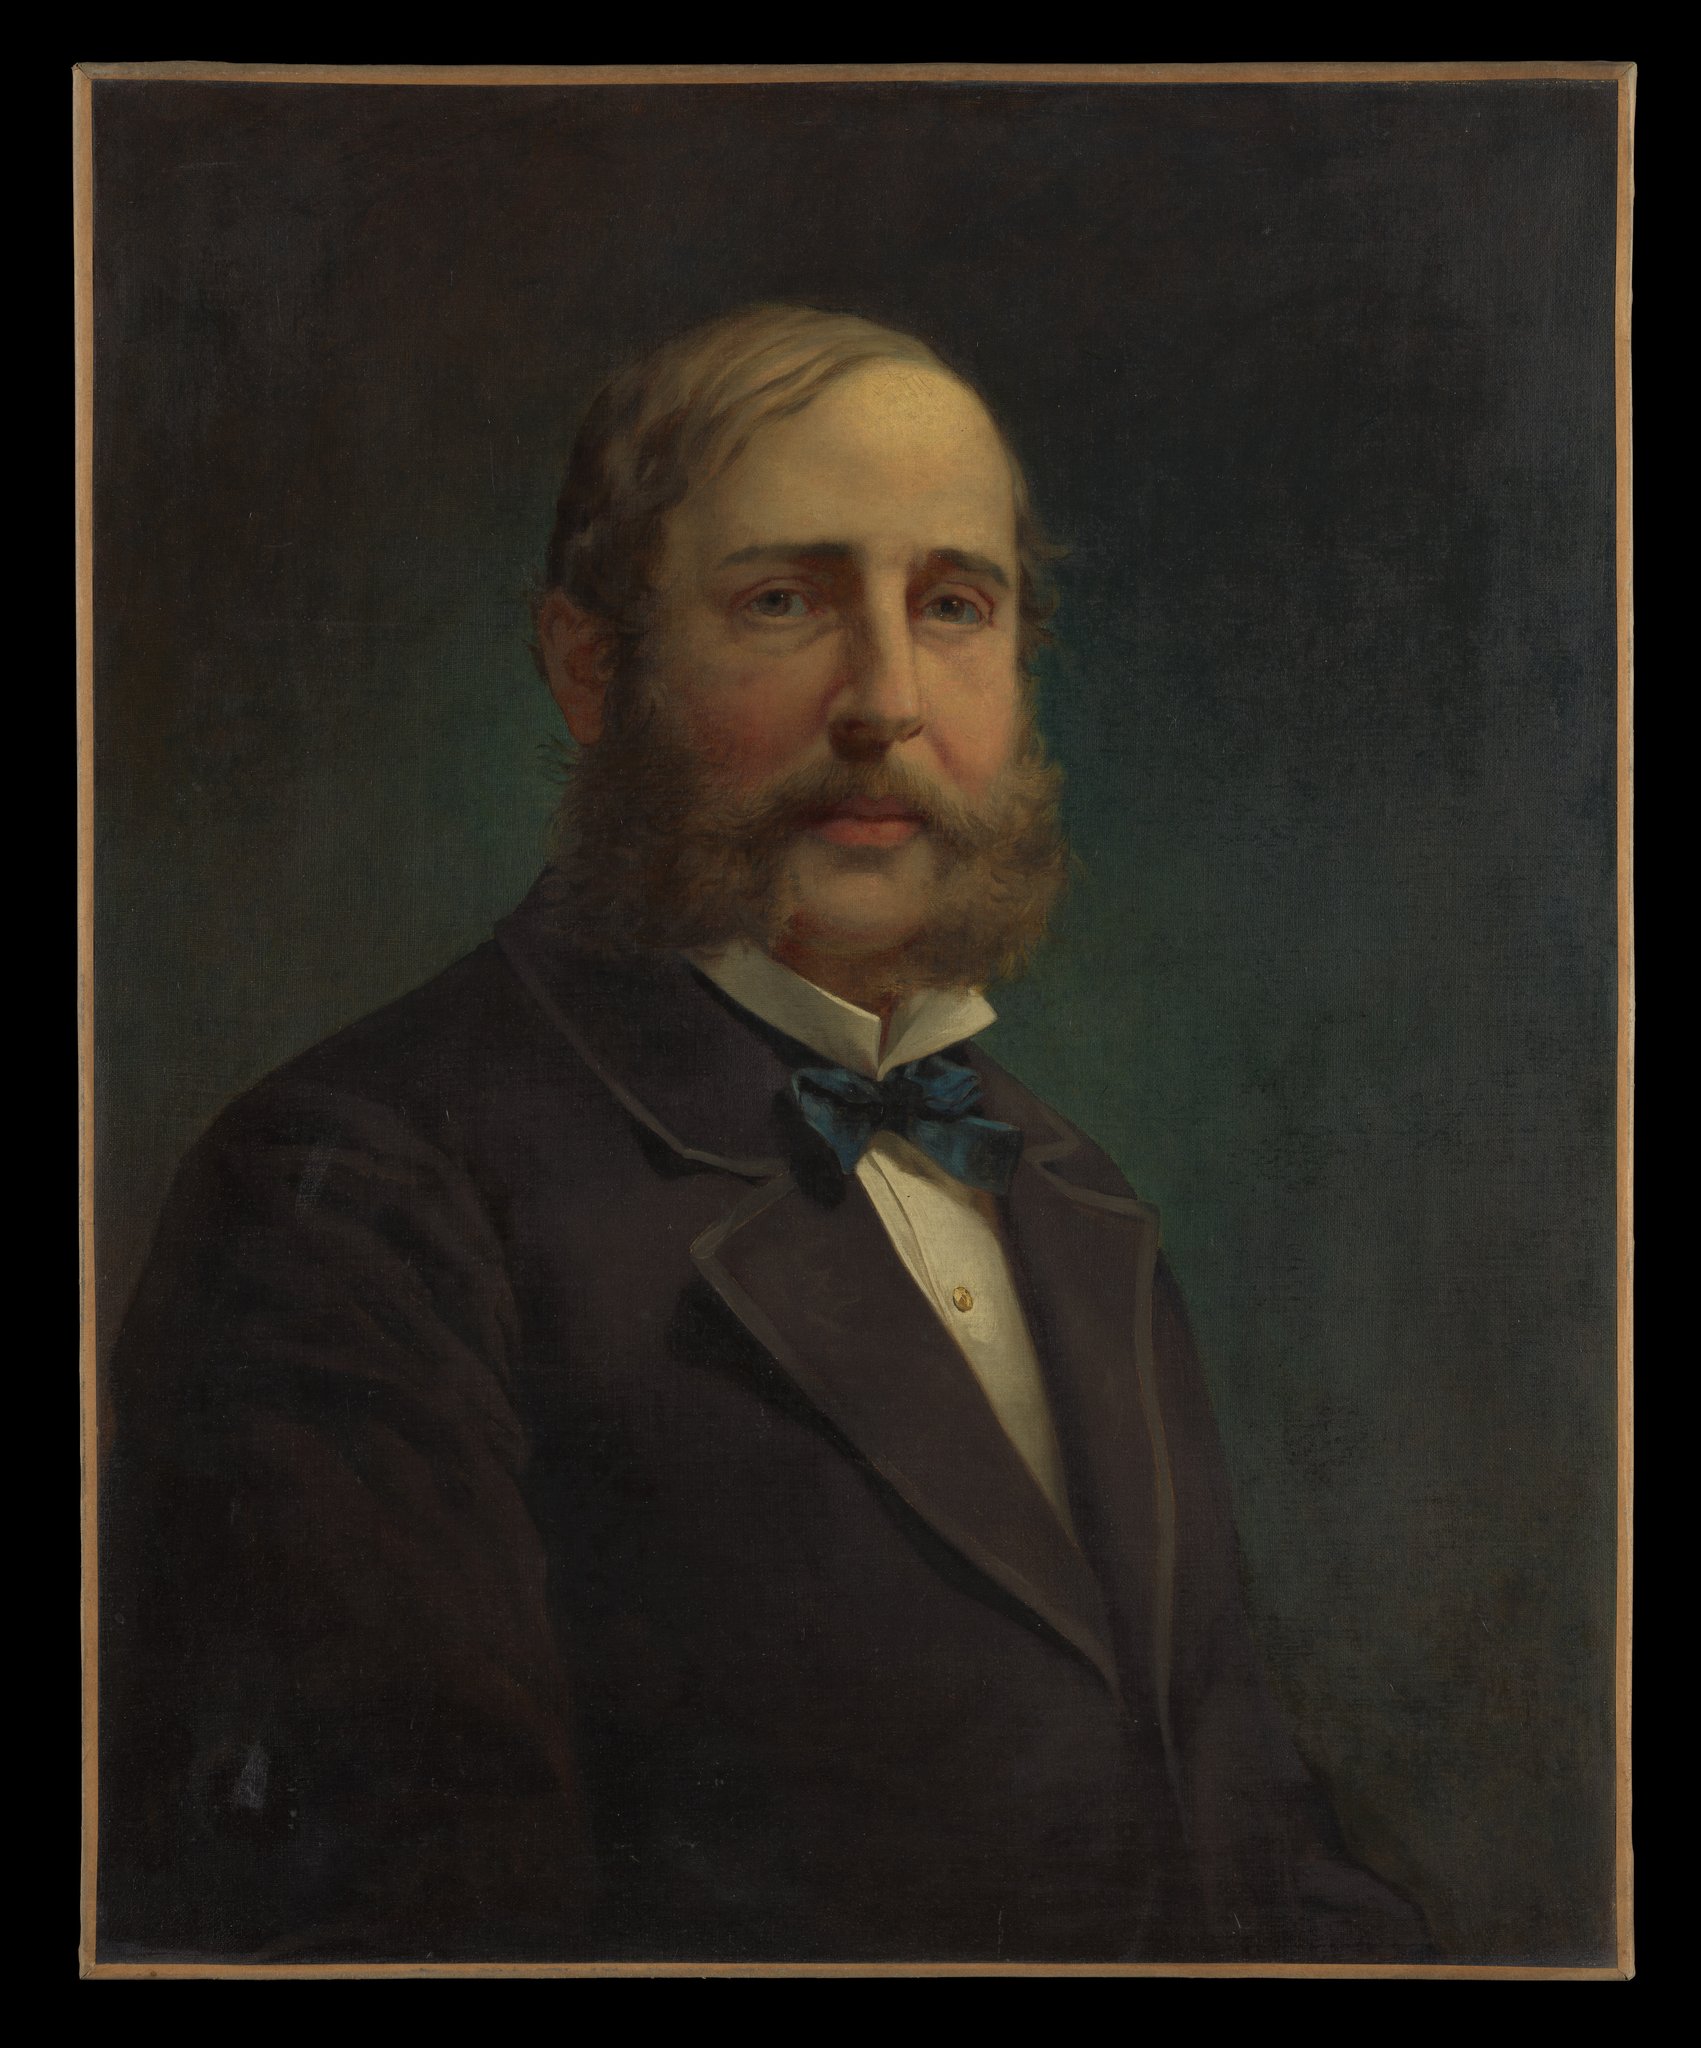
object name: painting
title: Self-portrait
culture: american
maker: jacob hart lazarus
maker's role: artist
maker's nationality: american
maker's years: 1822-1891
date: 1870-1880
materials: canvas, oil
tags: men,self-portraits